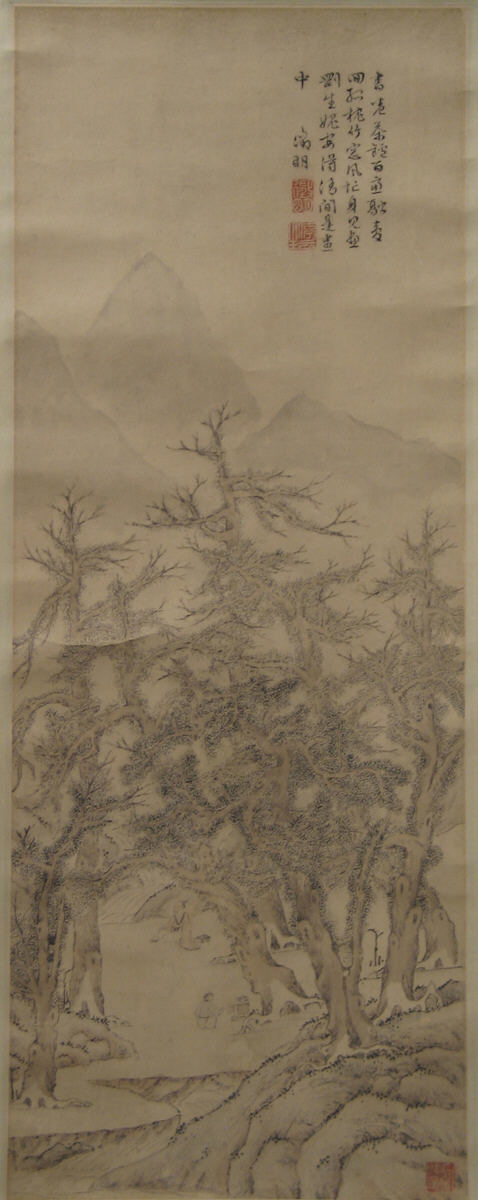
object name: hanging scroll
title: Scholar Seated in Grove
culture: chinese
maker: unidentified artist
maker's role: artist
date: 1500-1599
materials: ink, paper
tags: landscapes,trees